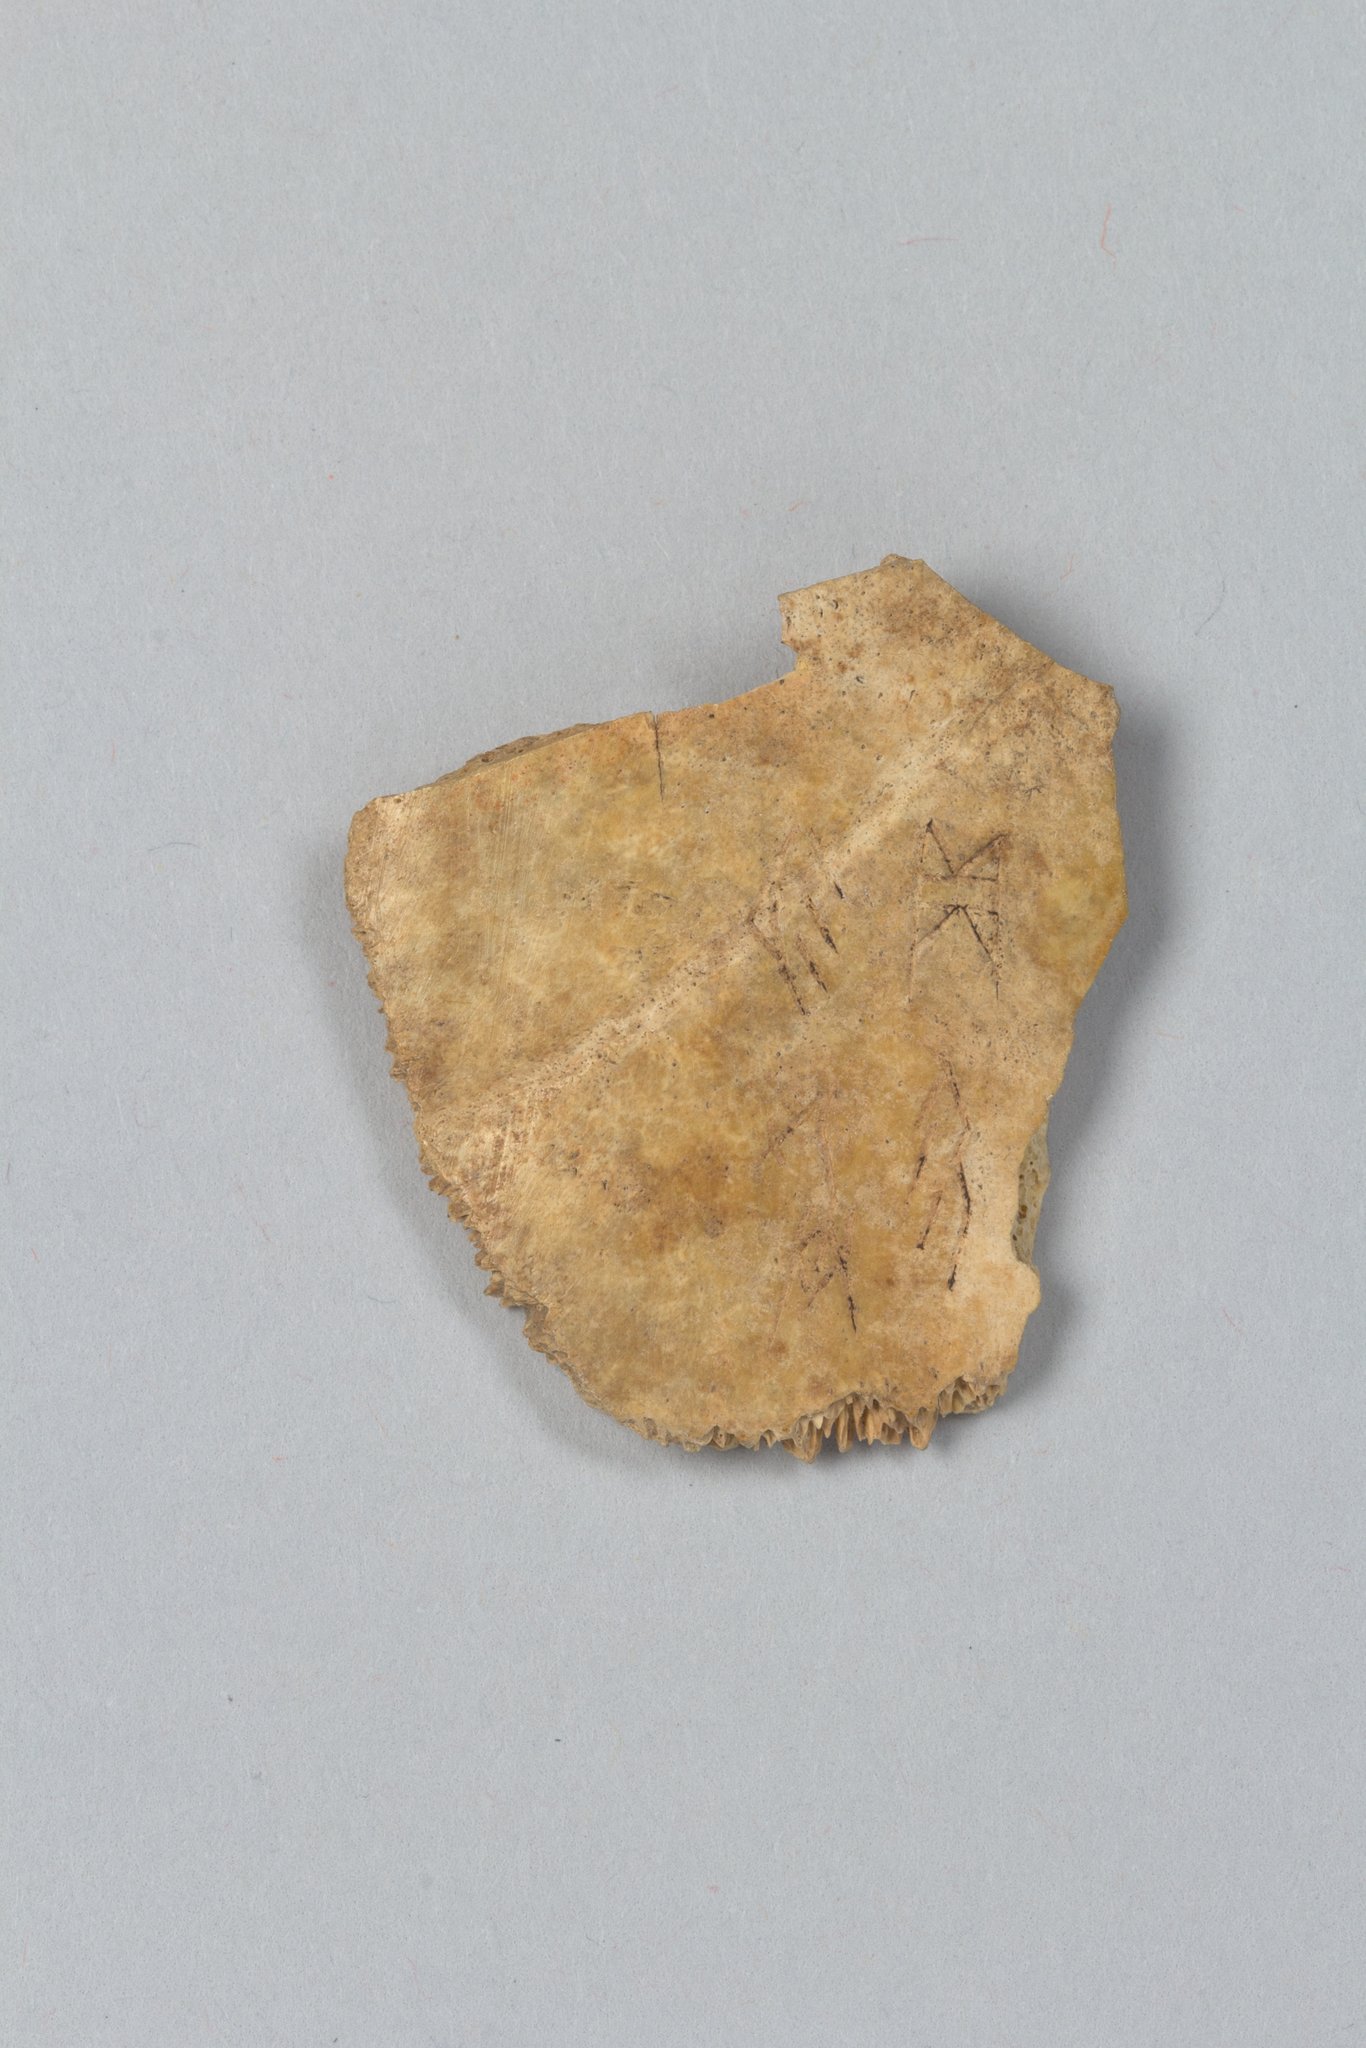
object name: oracle bone fragment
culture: chinese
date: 1300-1001 BCE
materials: bone